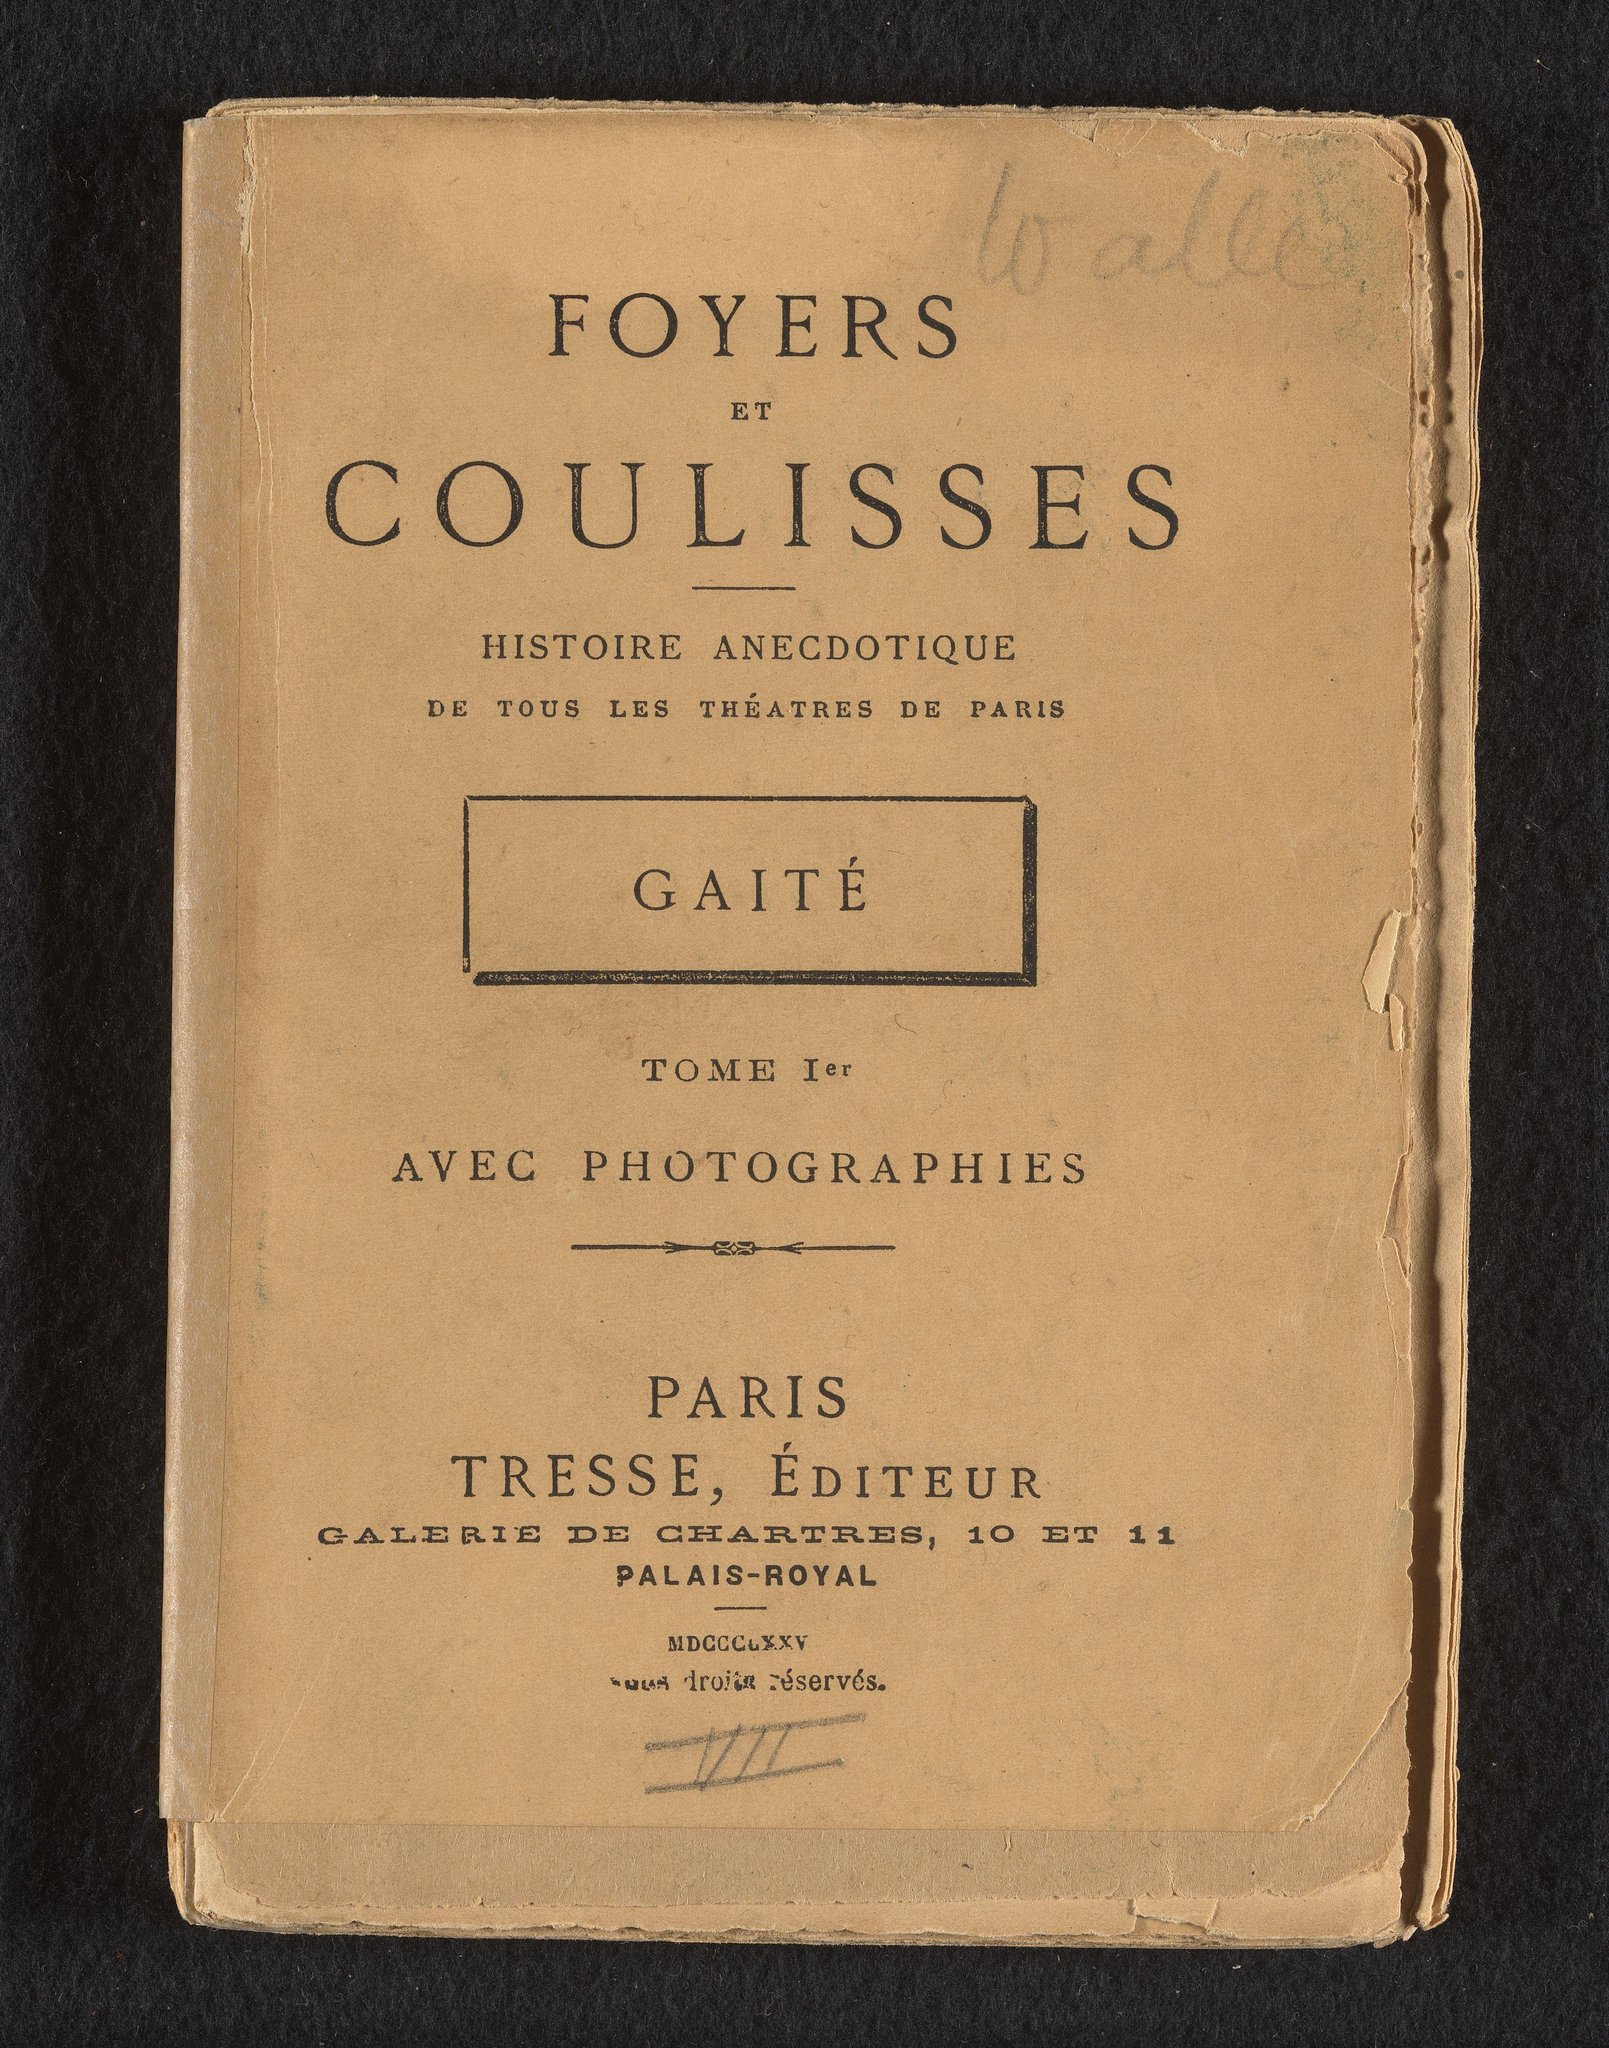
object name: book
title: Foyers et coulisses : histoire anecdotique de tous les théatres de Paris : Gaité : tome premier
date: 1875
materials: cardboard, paper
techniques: letterpress printing, woodburytype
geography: paris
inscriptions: inscription: ‘Walle/ VII’